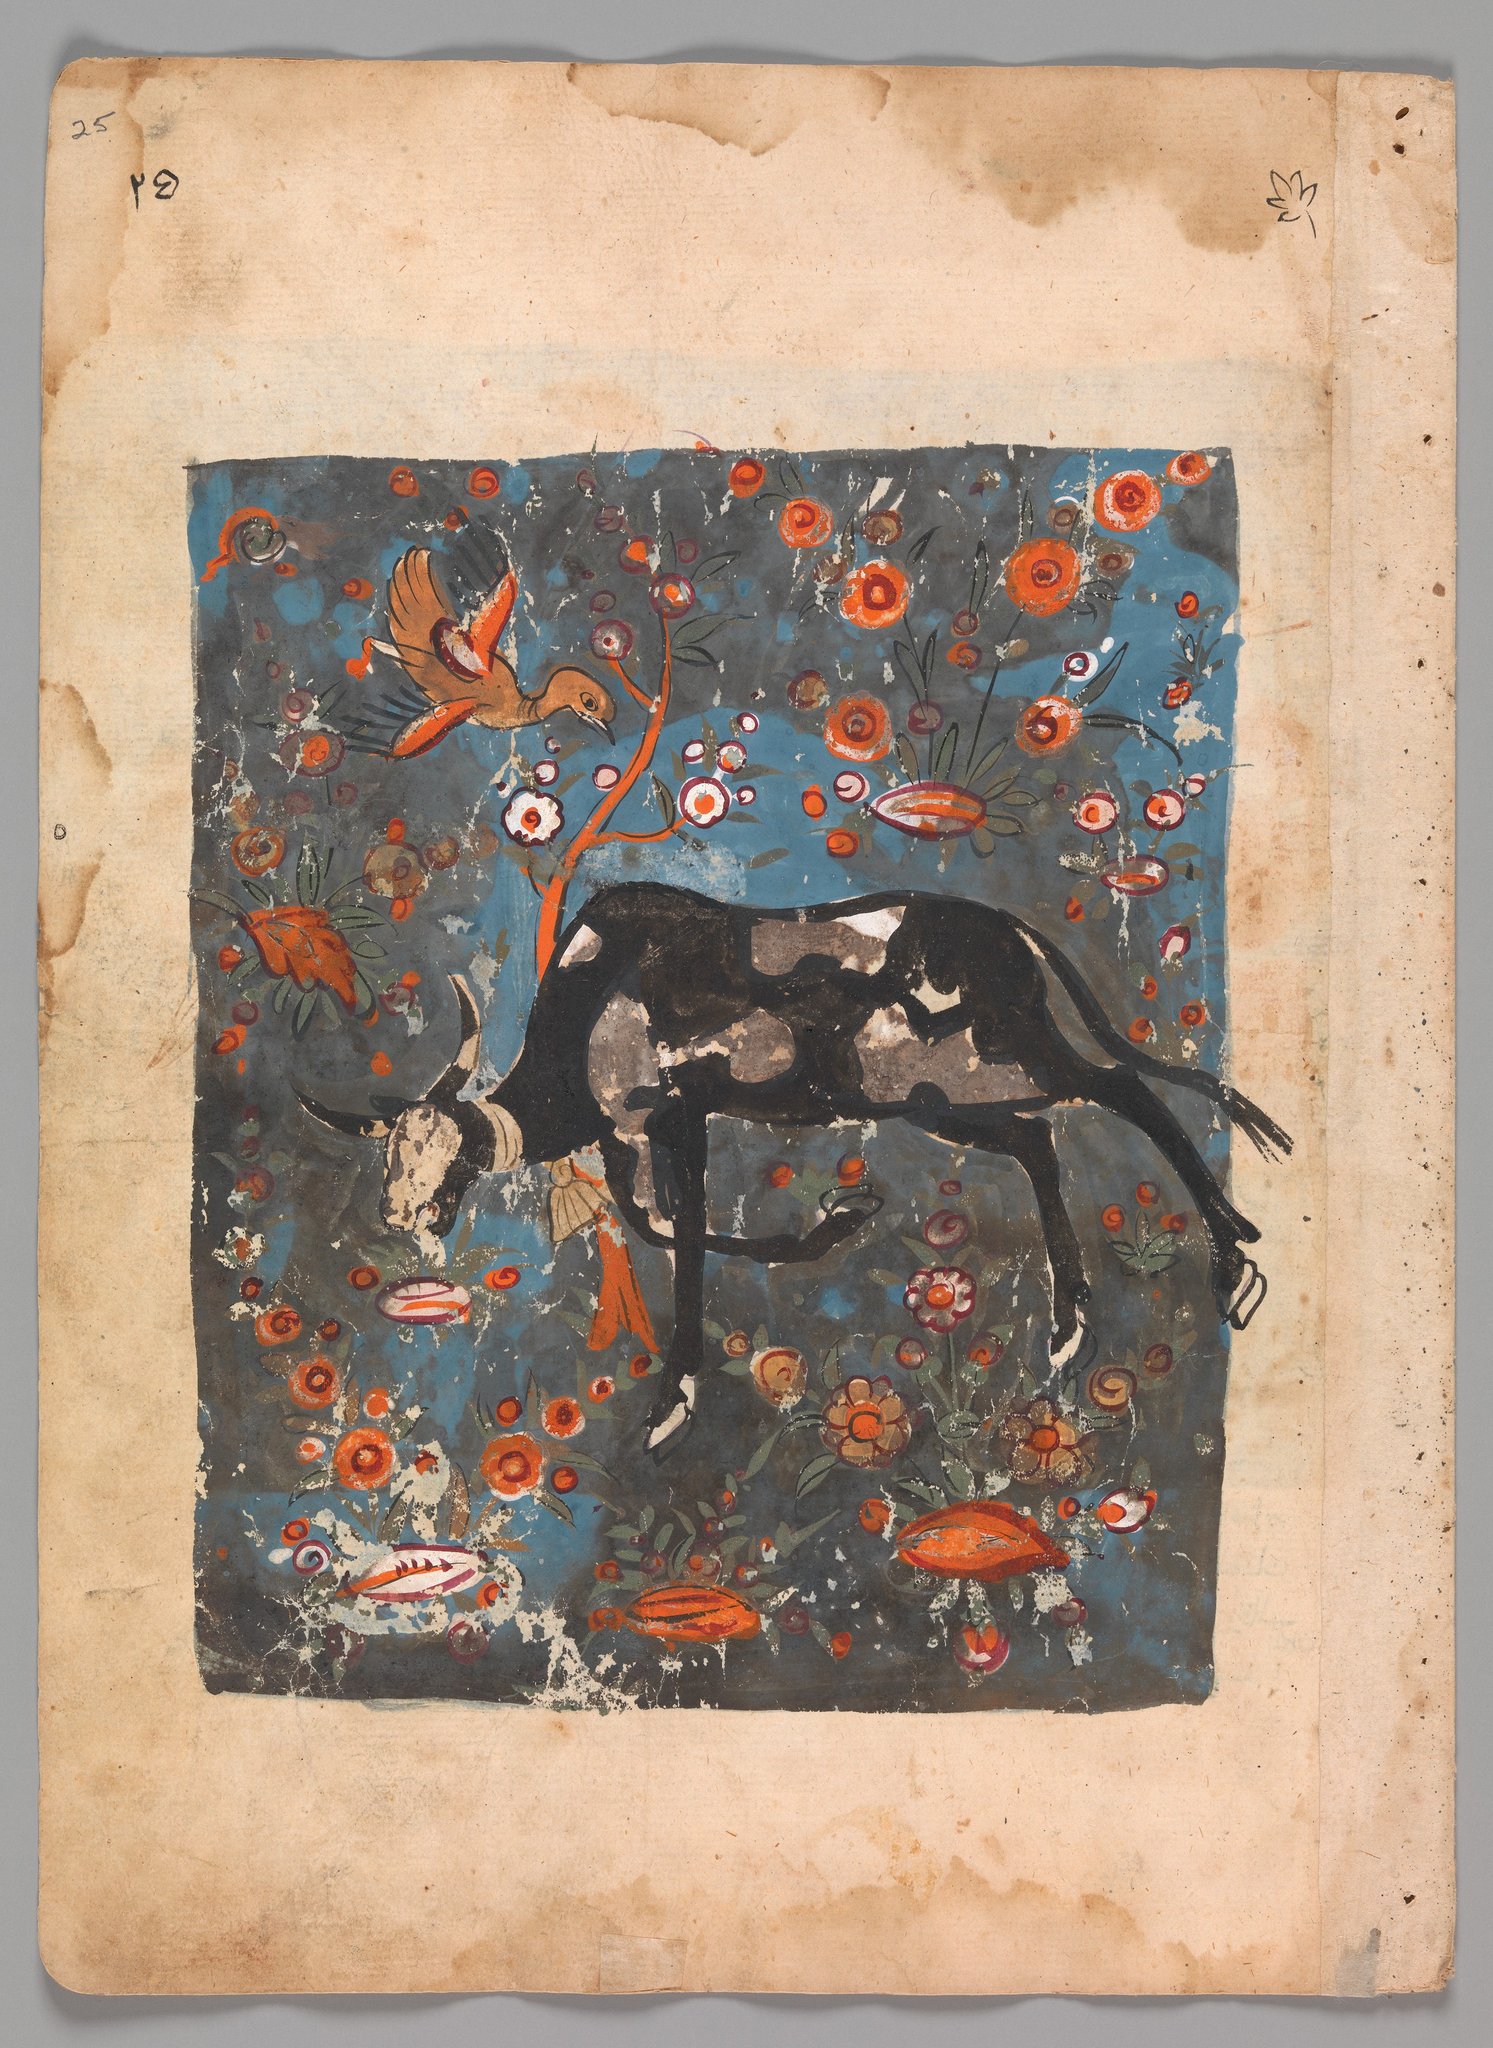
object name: folio from an illustrated manuscript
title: "The Ox Shanzabeh Left Behind, Grazing in the Territory of the Lion King", Folio from a Kalila wa Dimna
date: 1526-1550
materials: ink, paper, watercolor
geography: india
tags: animals,birds,flowers